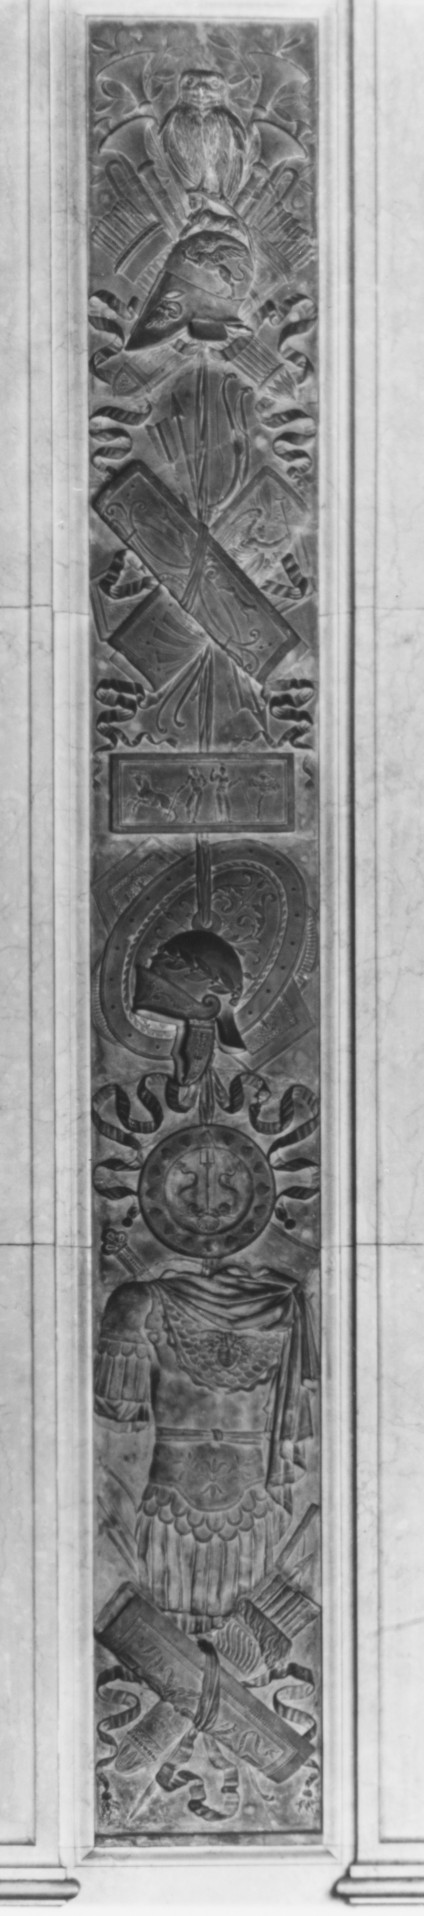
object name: pilaster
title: Pilaster (one of four)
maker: graziani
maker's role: artist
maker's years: 1762-1835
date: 1767-1833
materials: terracotta